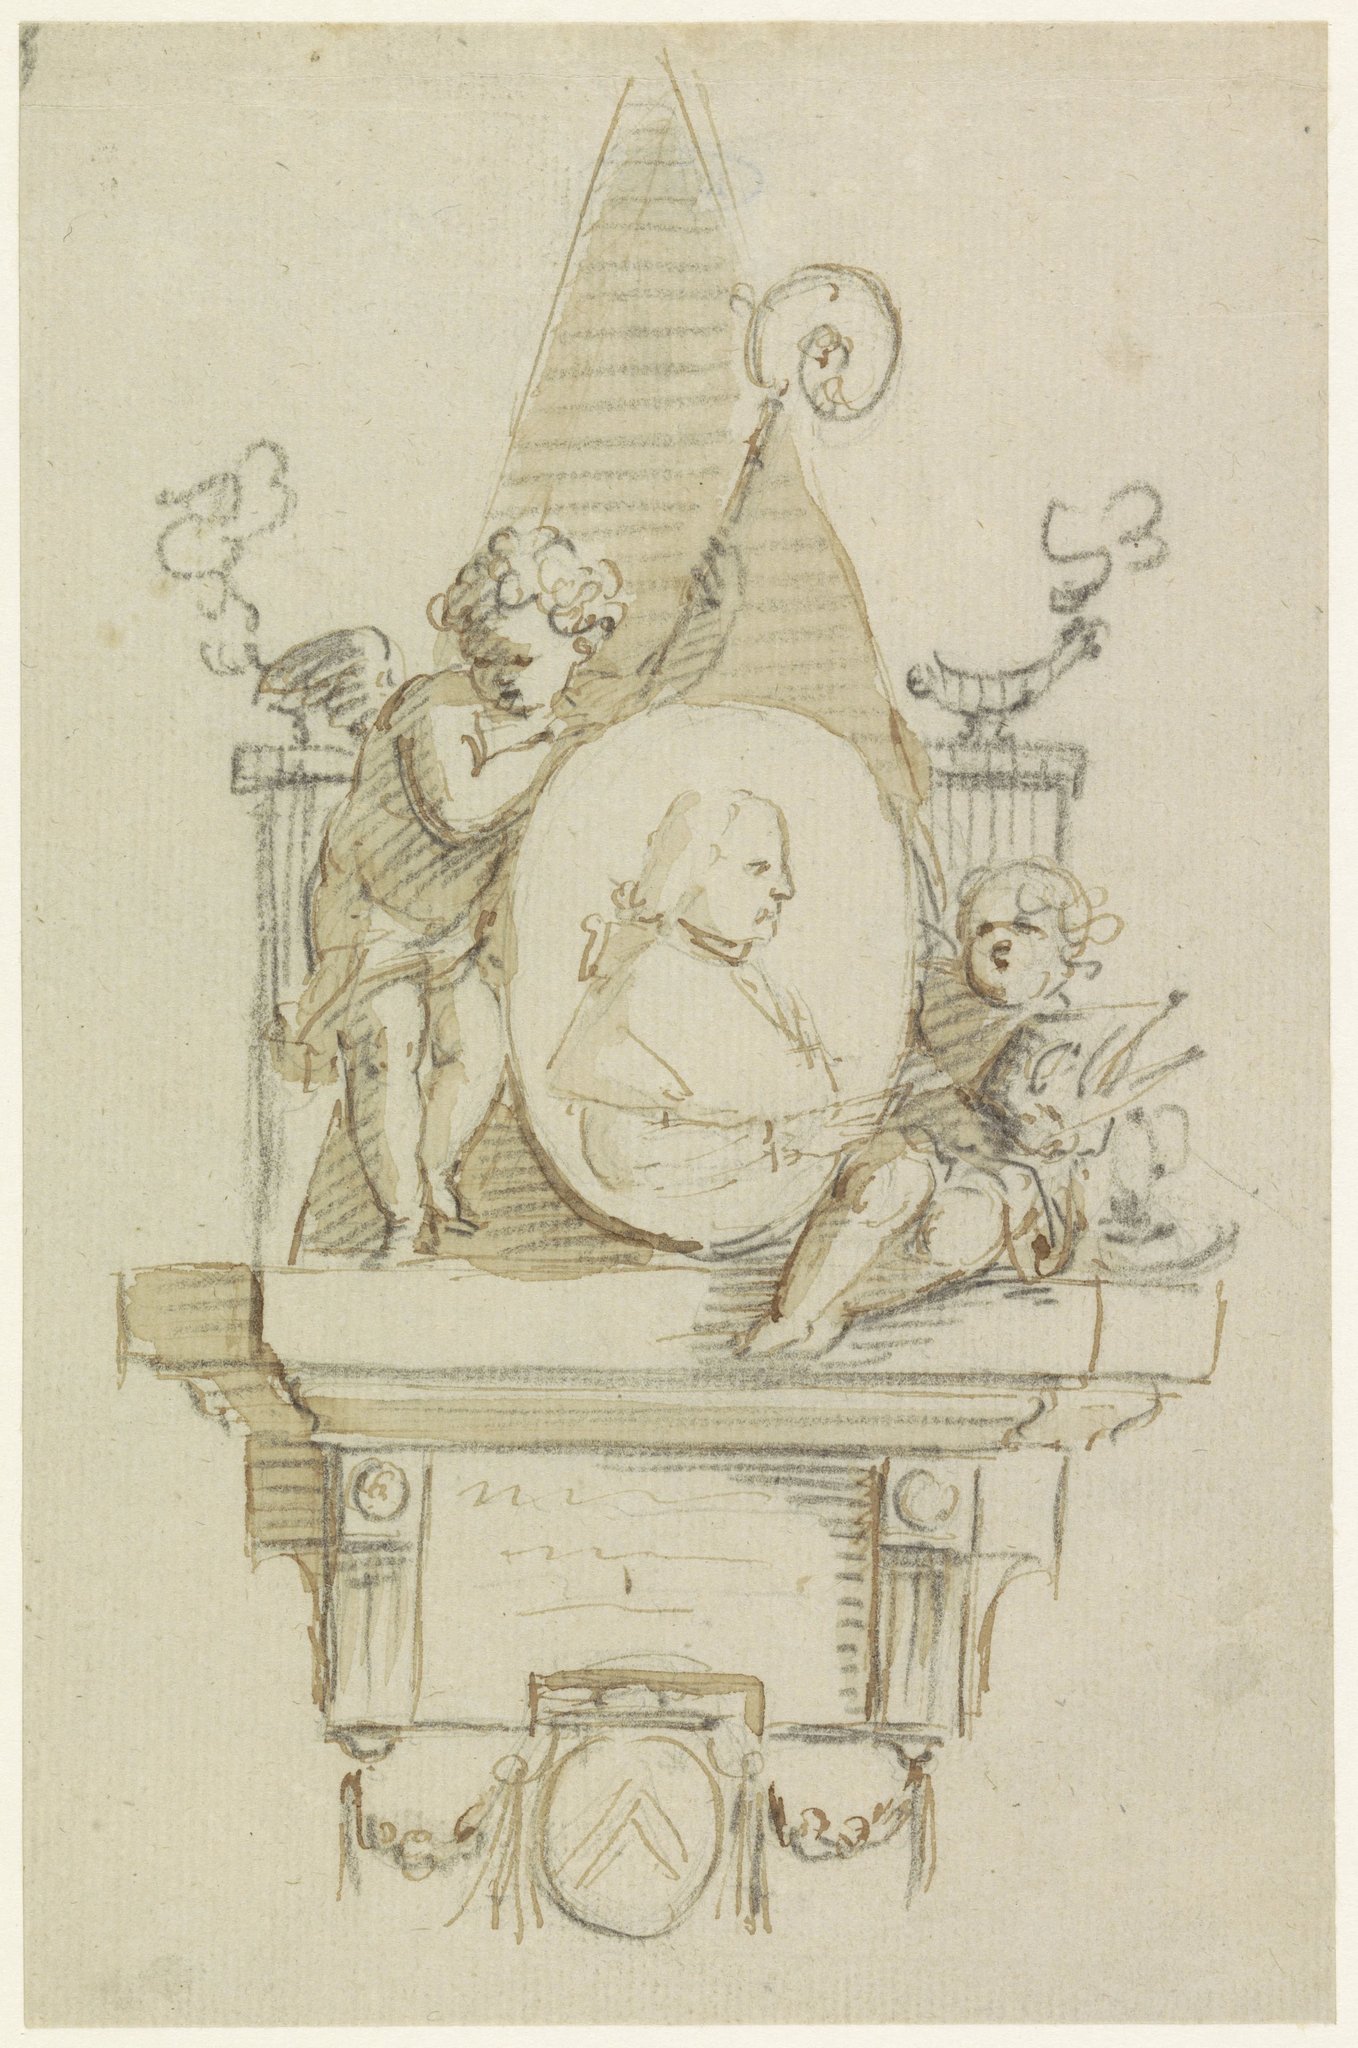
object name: design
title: Ontwerp voor een grafmonument voor een abt of bisschop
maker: Anonymous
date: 1700-1800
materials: chalk, ink, paper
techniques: brush, pen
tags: grave-building, monumental tomb